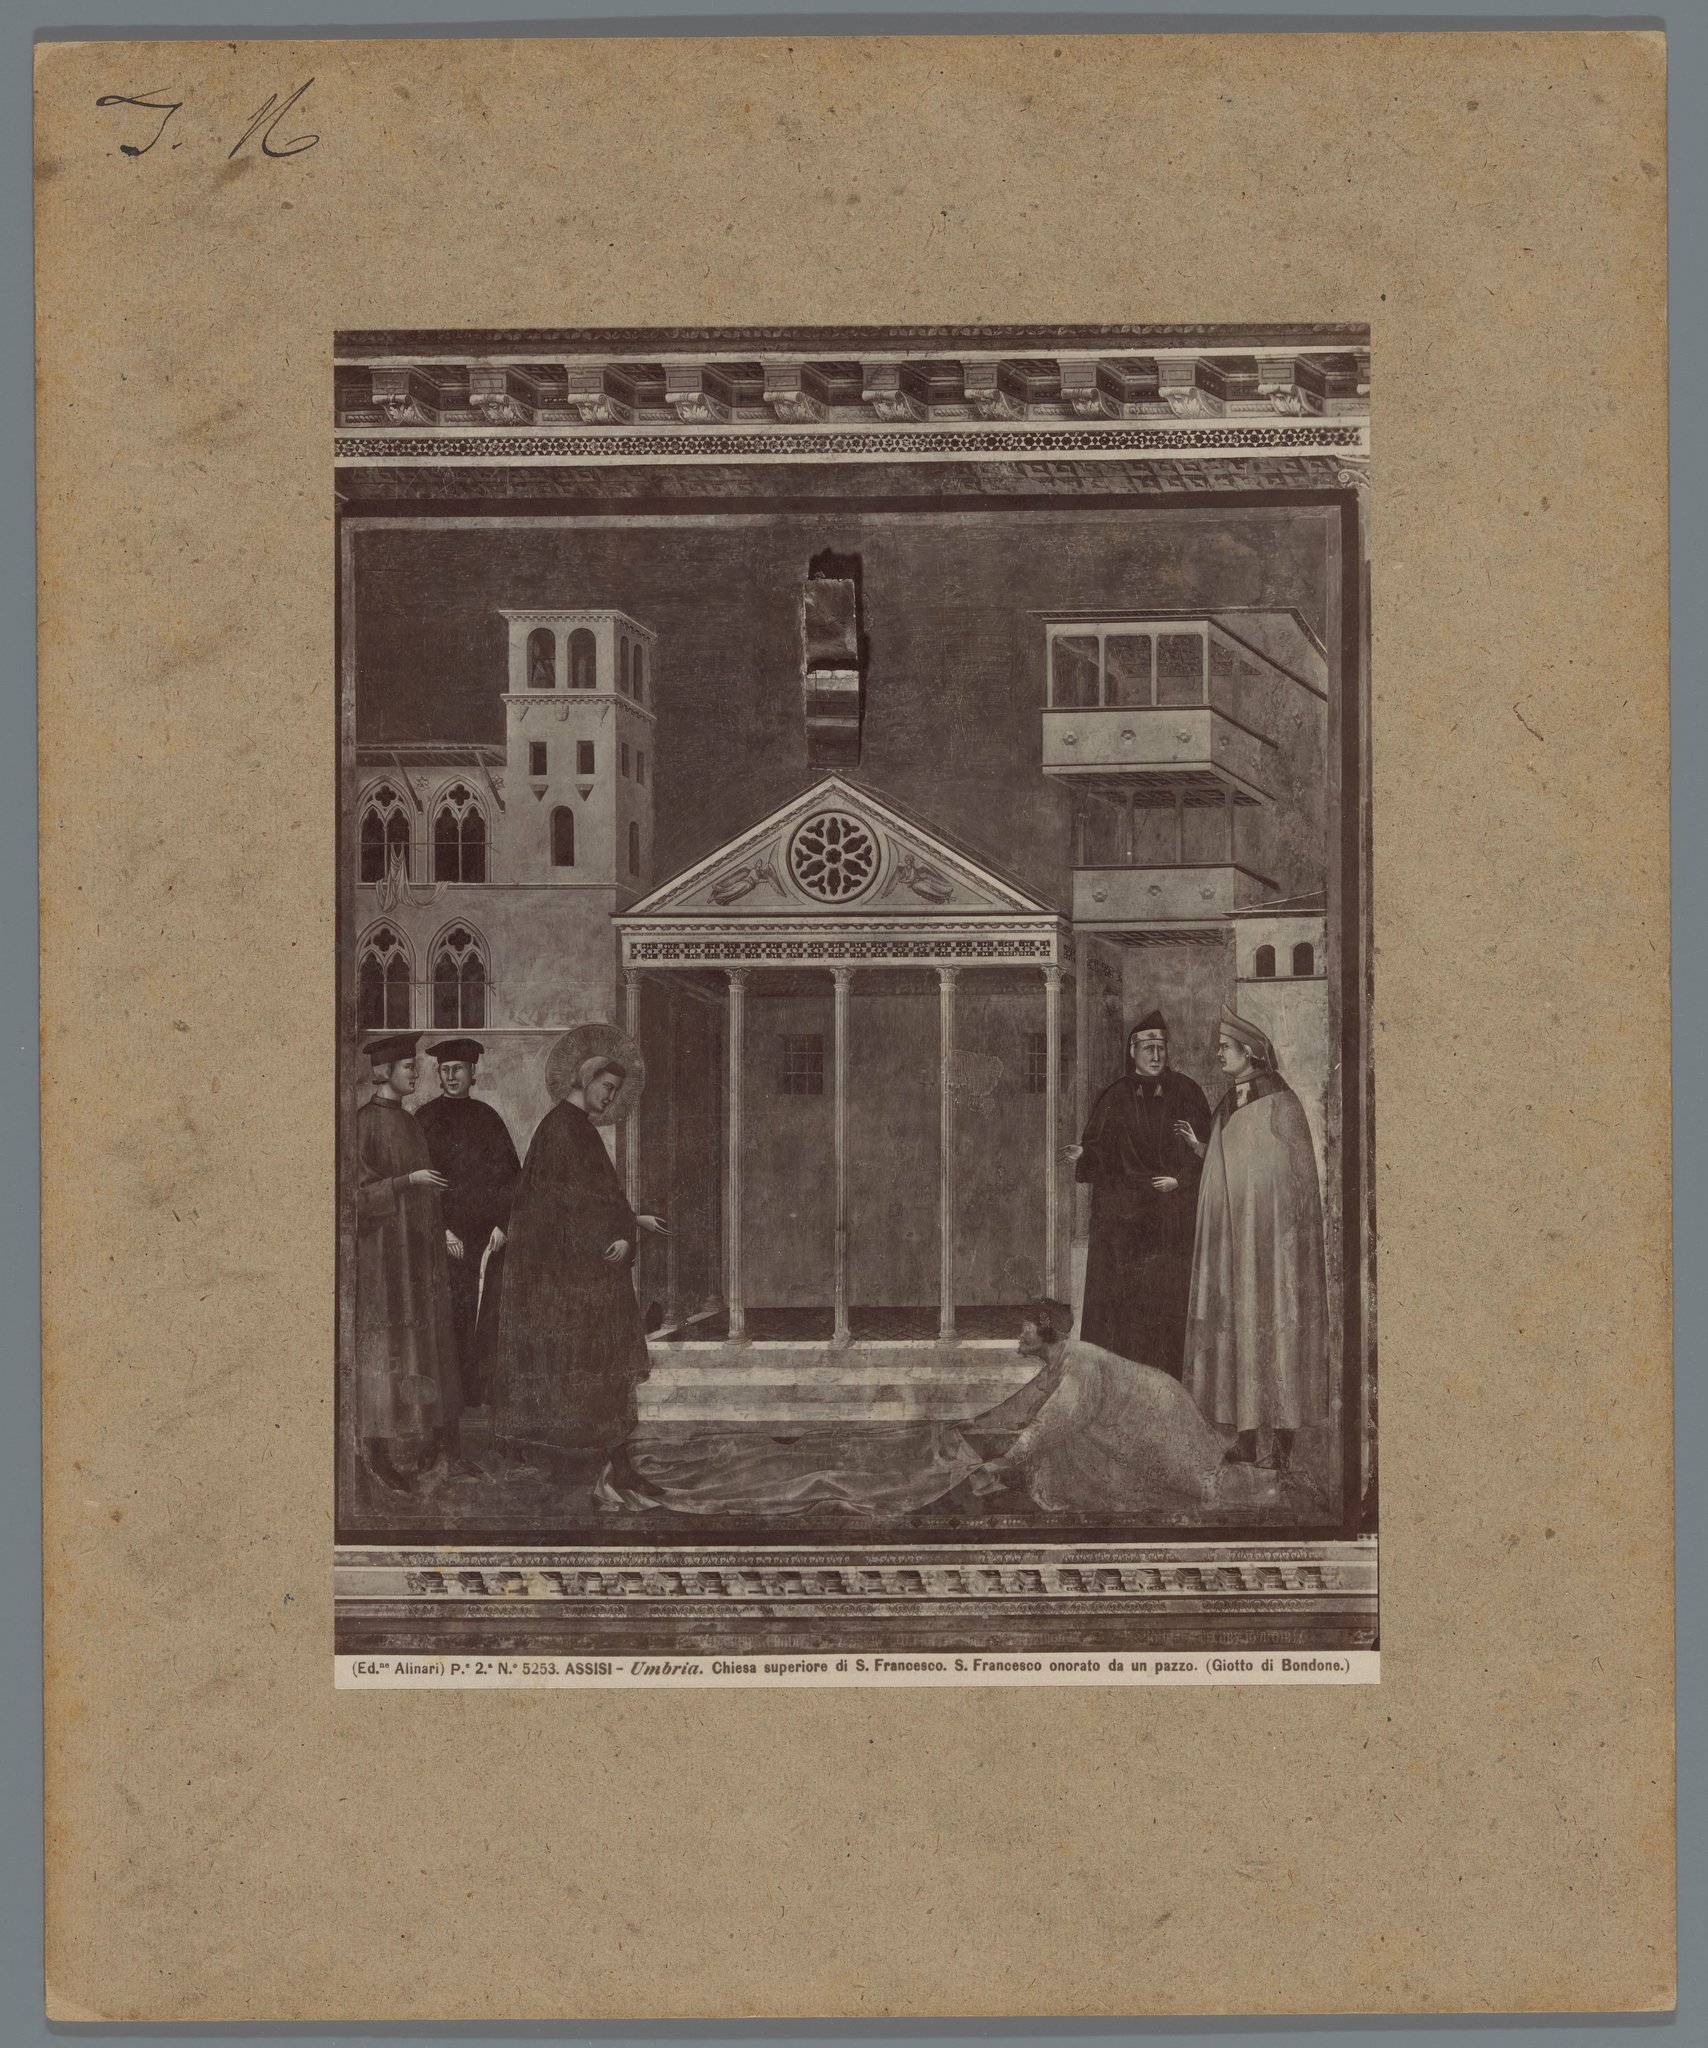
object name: photograph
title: ASSISI - Umbria. Chiesa superiore di S. Francesco. S. Francesco onorato da un pazzo.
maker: giotto de bondone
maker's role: painter, sculptor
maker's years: 1266-1337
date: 1875-1900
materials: cardboard, photographic support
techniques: albumen print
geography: sint-franciscusbasiliek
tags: non-miraculous activities and events ~ st. francis of assisi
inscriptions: number: ‘P.e 2.a N.o 5253.’, collector's mark: Lugt 3937